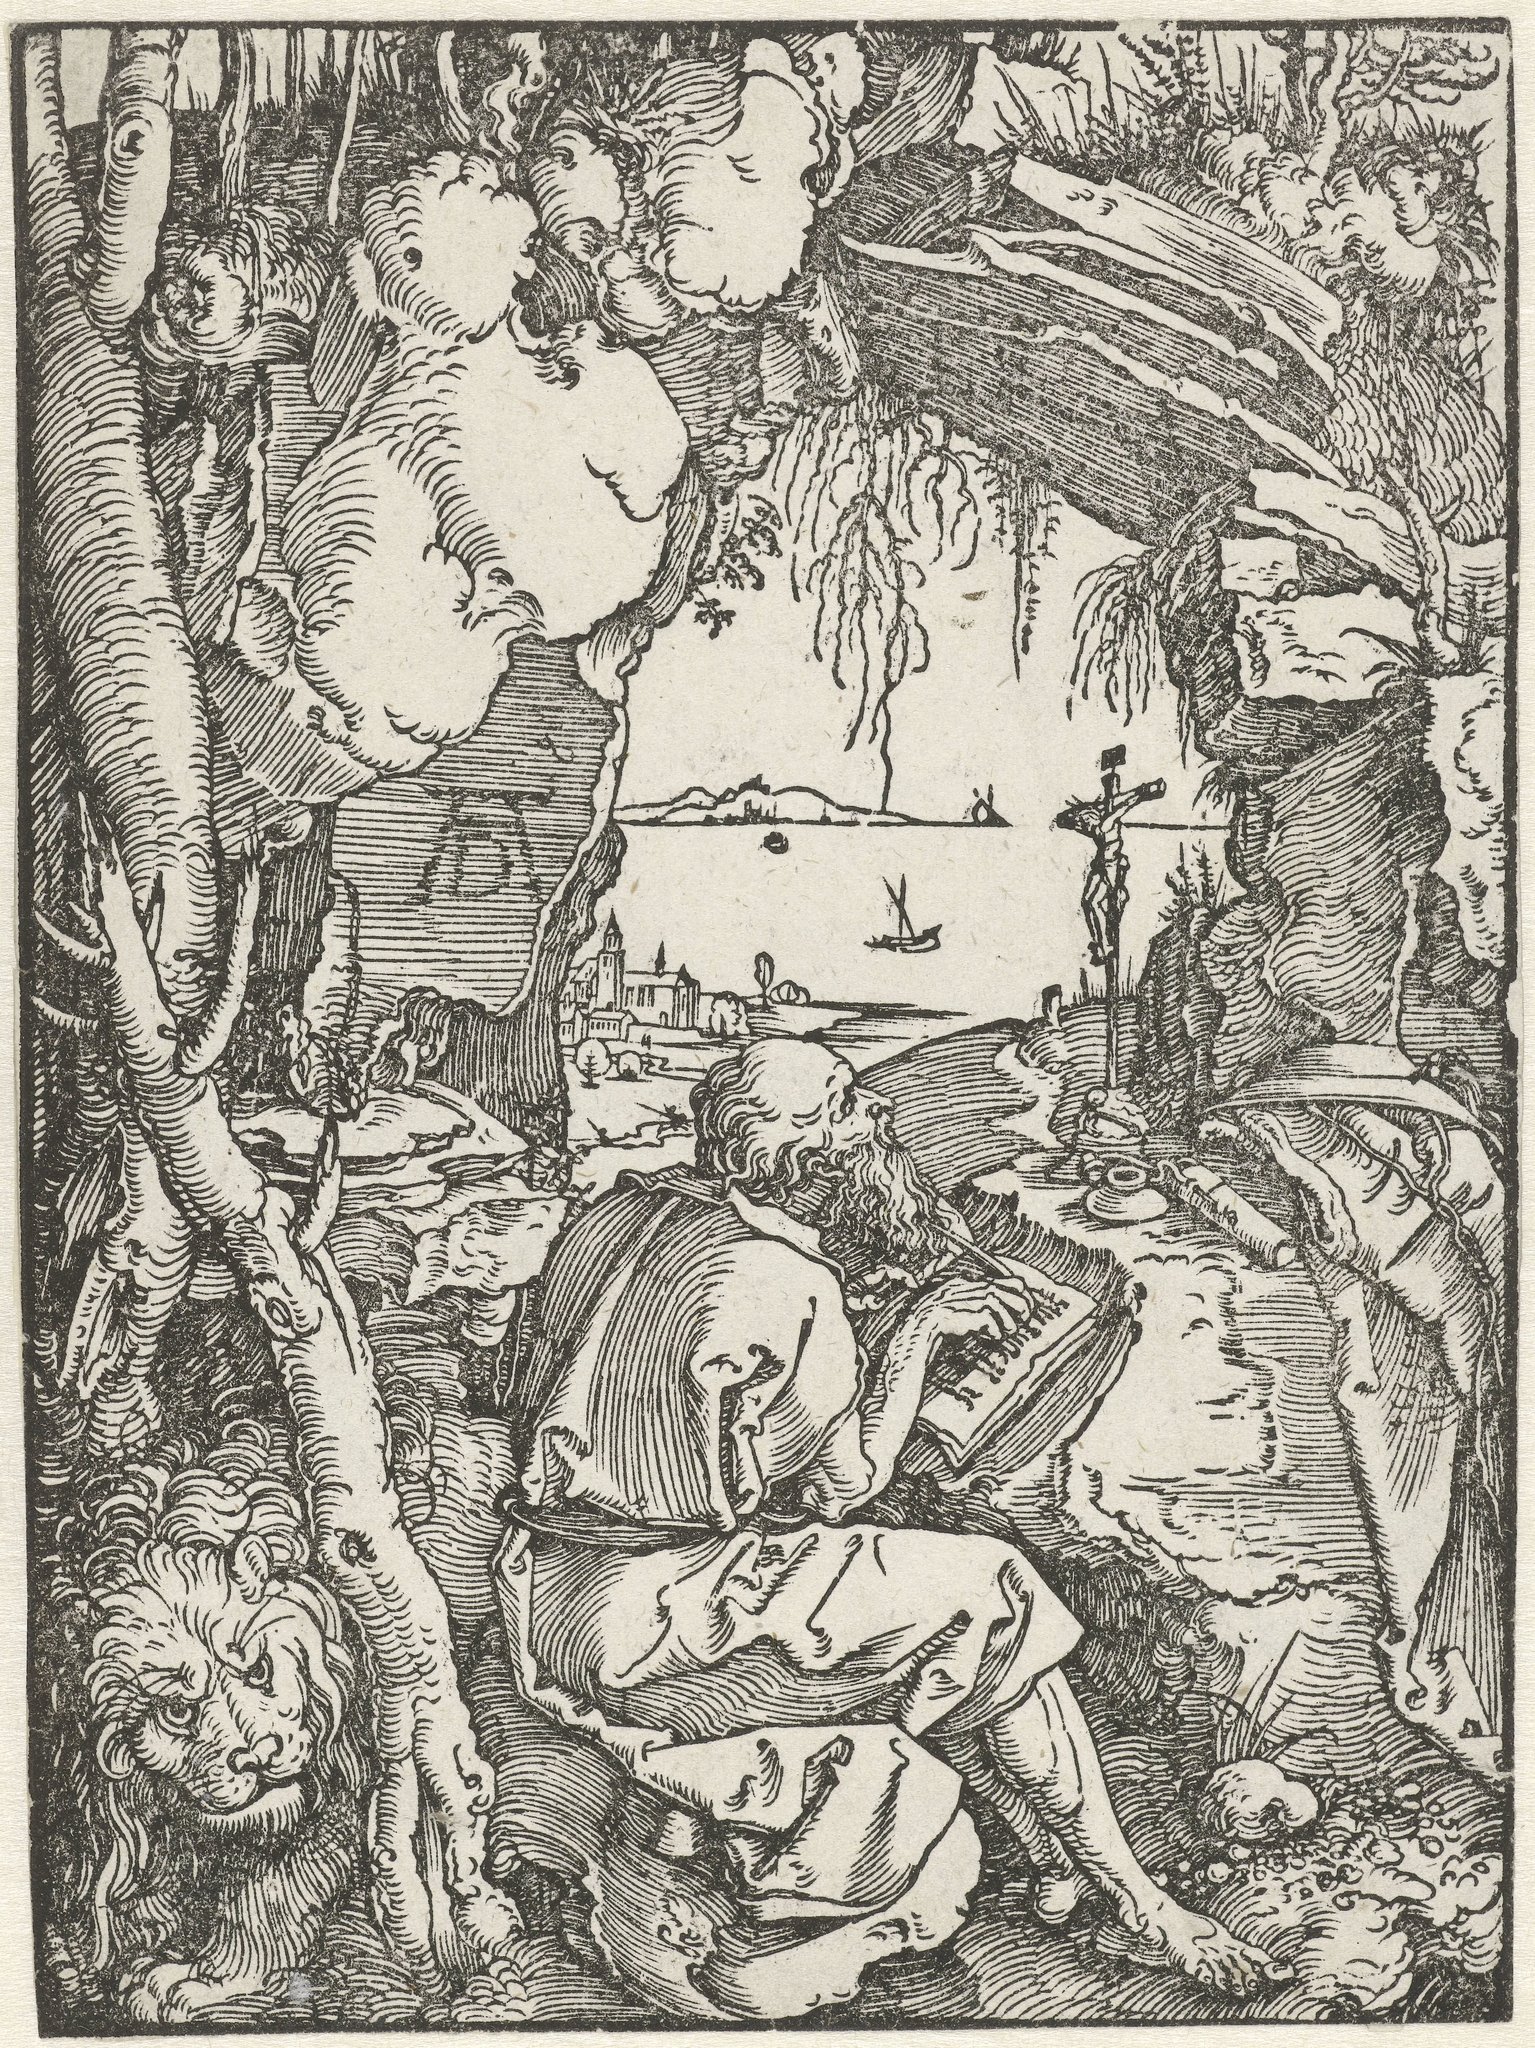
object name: print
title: De Heilige Hiëronymus schrijvend in een grot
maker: albrecht dürer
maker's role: draughtsman, painter, print maker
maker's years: 1471-1528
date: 1512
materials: paper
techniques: woodcut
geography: nuremberg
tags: personal devotion of st. jerome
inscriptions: collector's mark: Lugt 240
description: De Heilige Hiëronymus zit in een grot te schrijven. Achter hem staat een leeuw. Door de opening van de grot is een stadje aan een baai te zien.